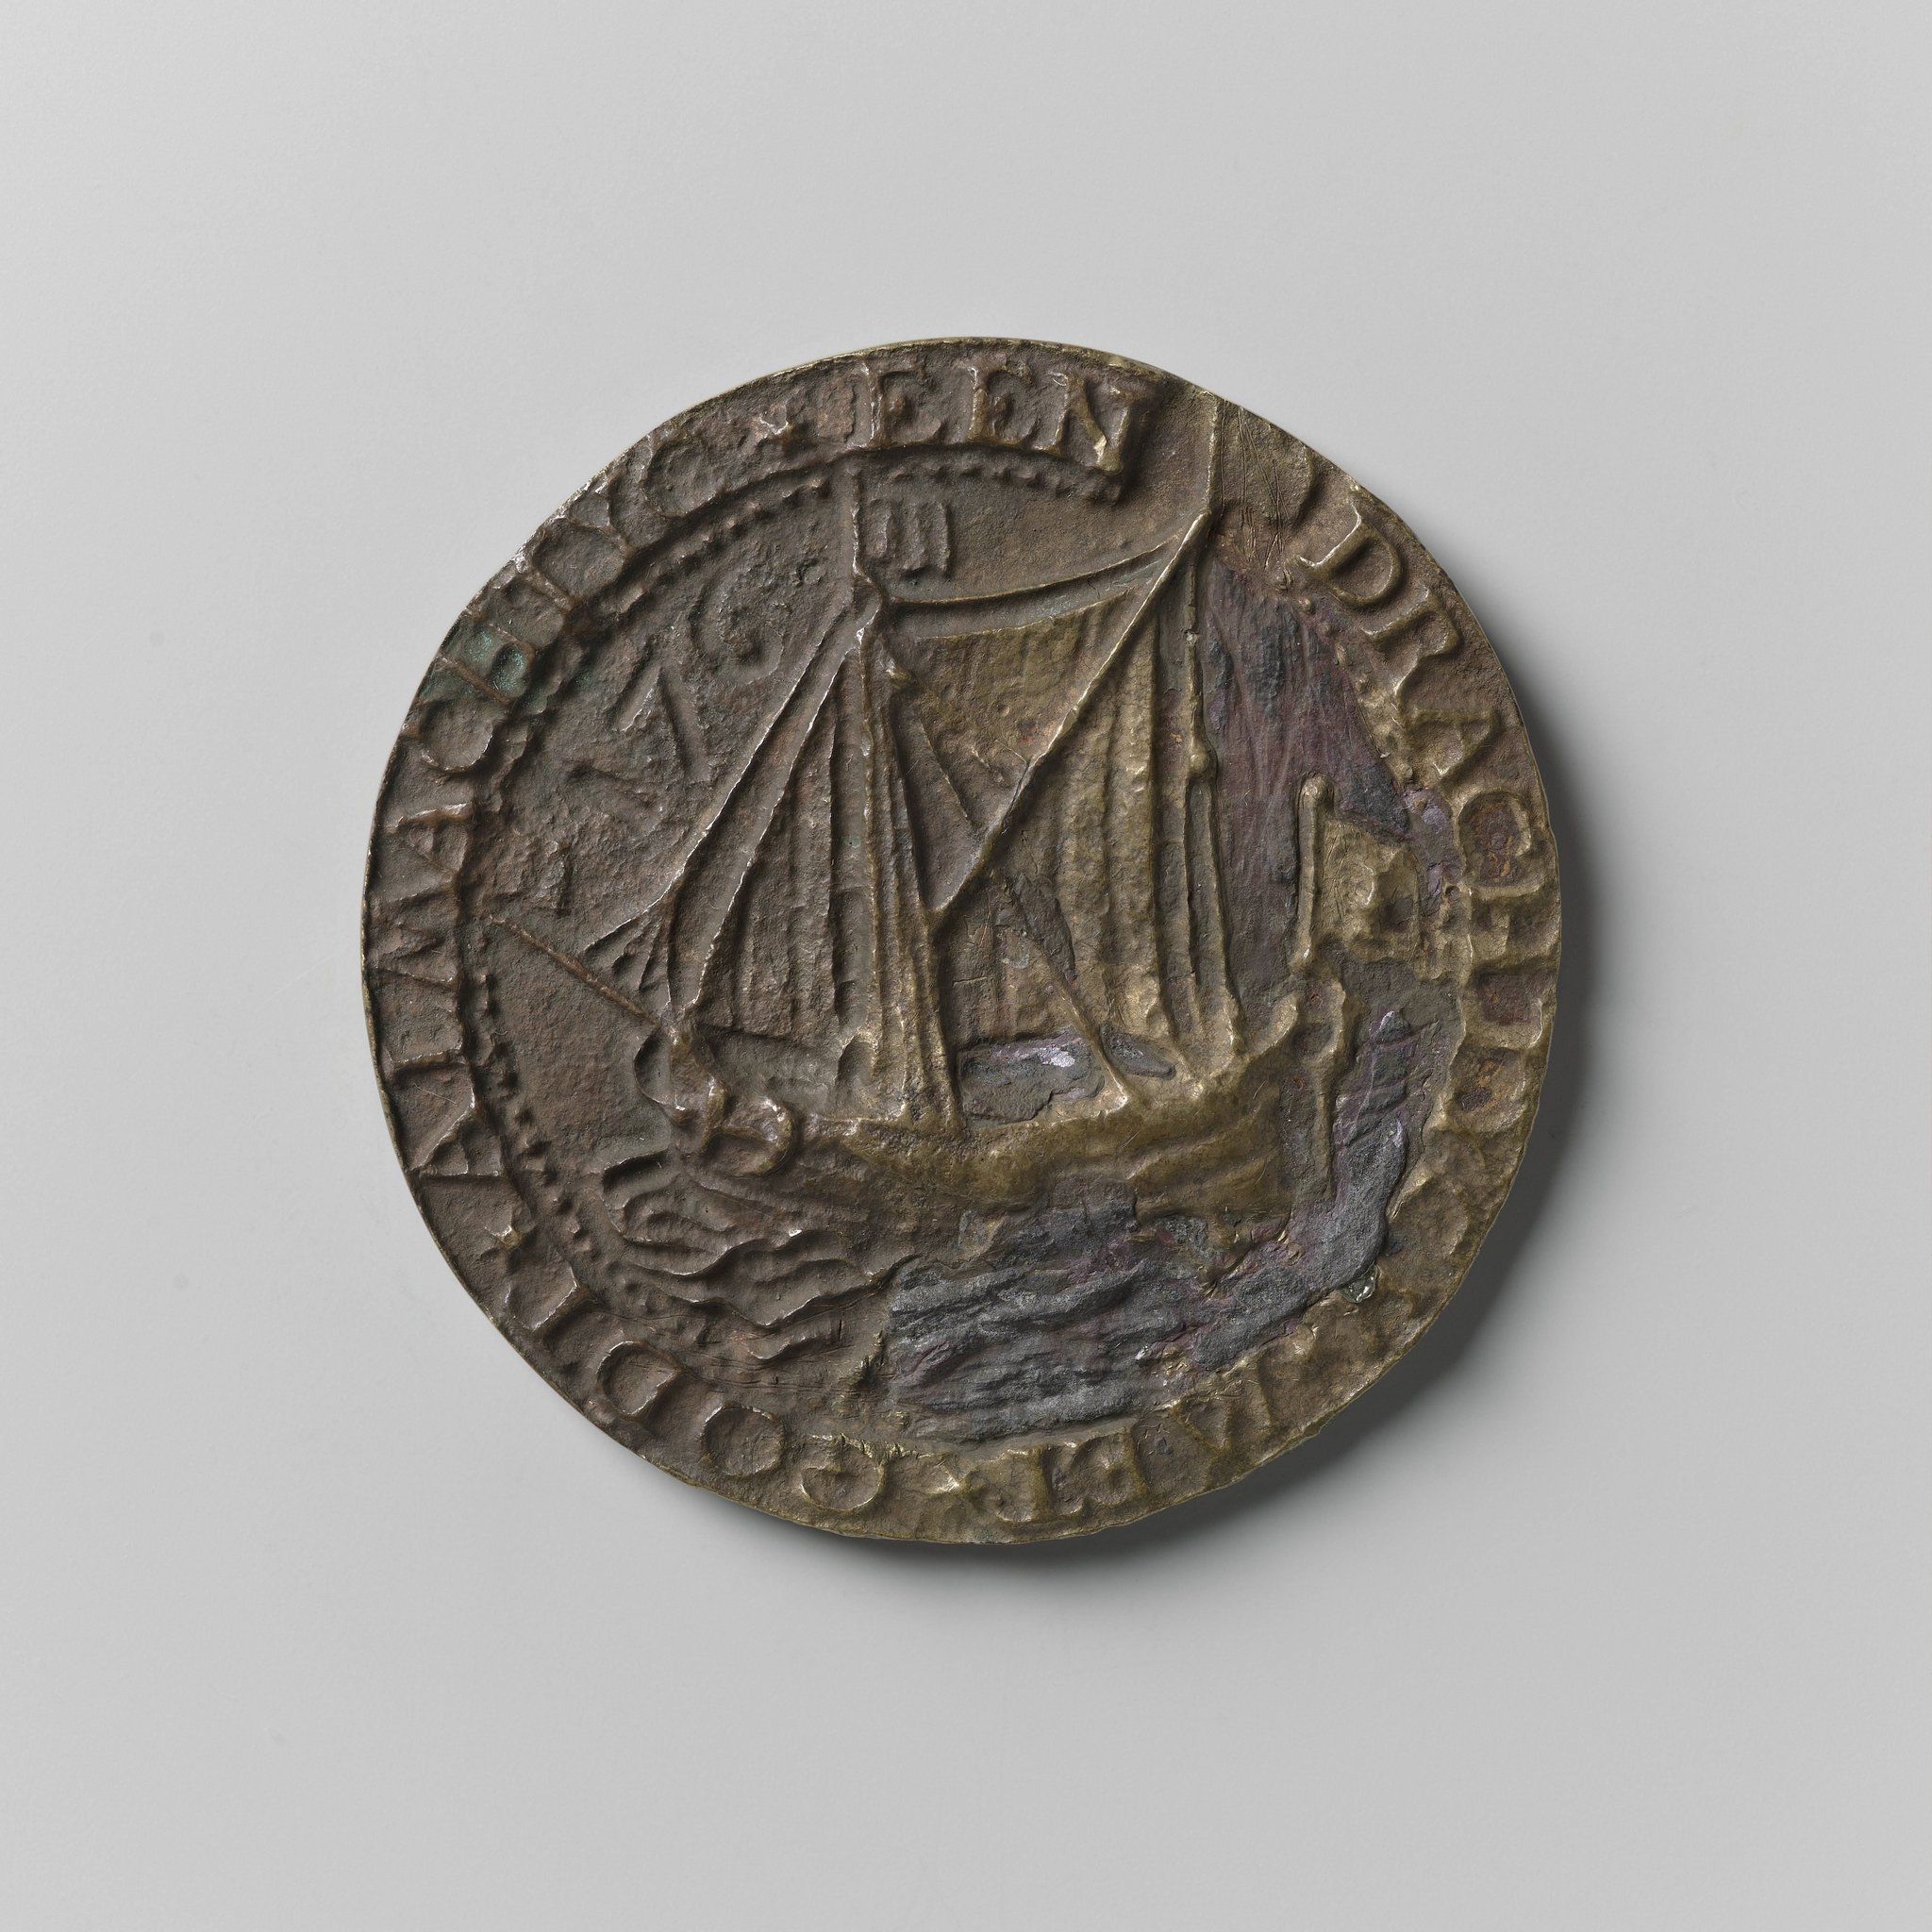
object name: medal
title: Grootschippersgilde, gildepenning van Barent Dircks Otmarinck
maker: Anonymous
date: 1600-1700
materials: silver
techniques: engraving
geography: netherlands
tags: barent dircks otmarinck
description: Zilveren penning met getande rand. Voorzijde: naar links varende driemaster boven opschrift. Keerzijde: gehelmd wapenschild